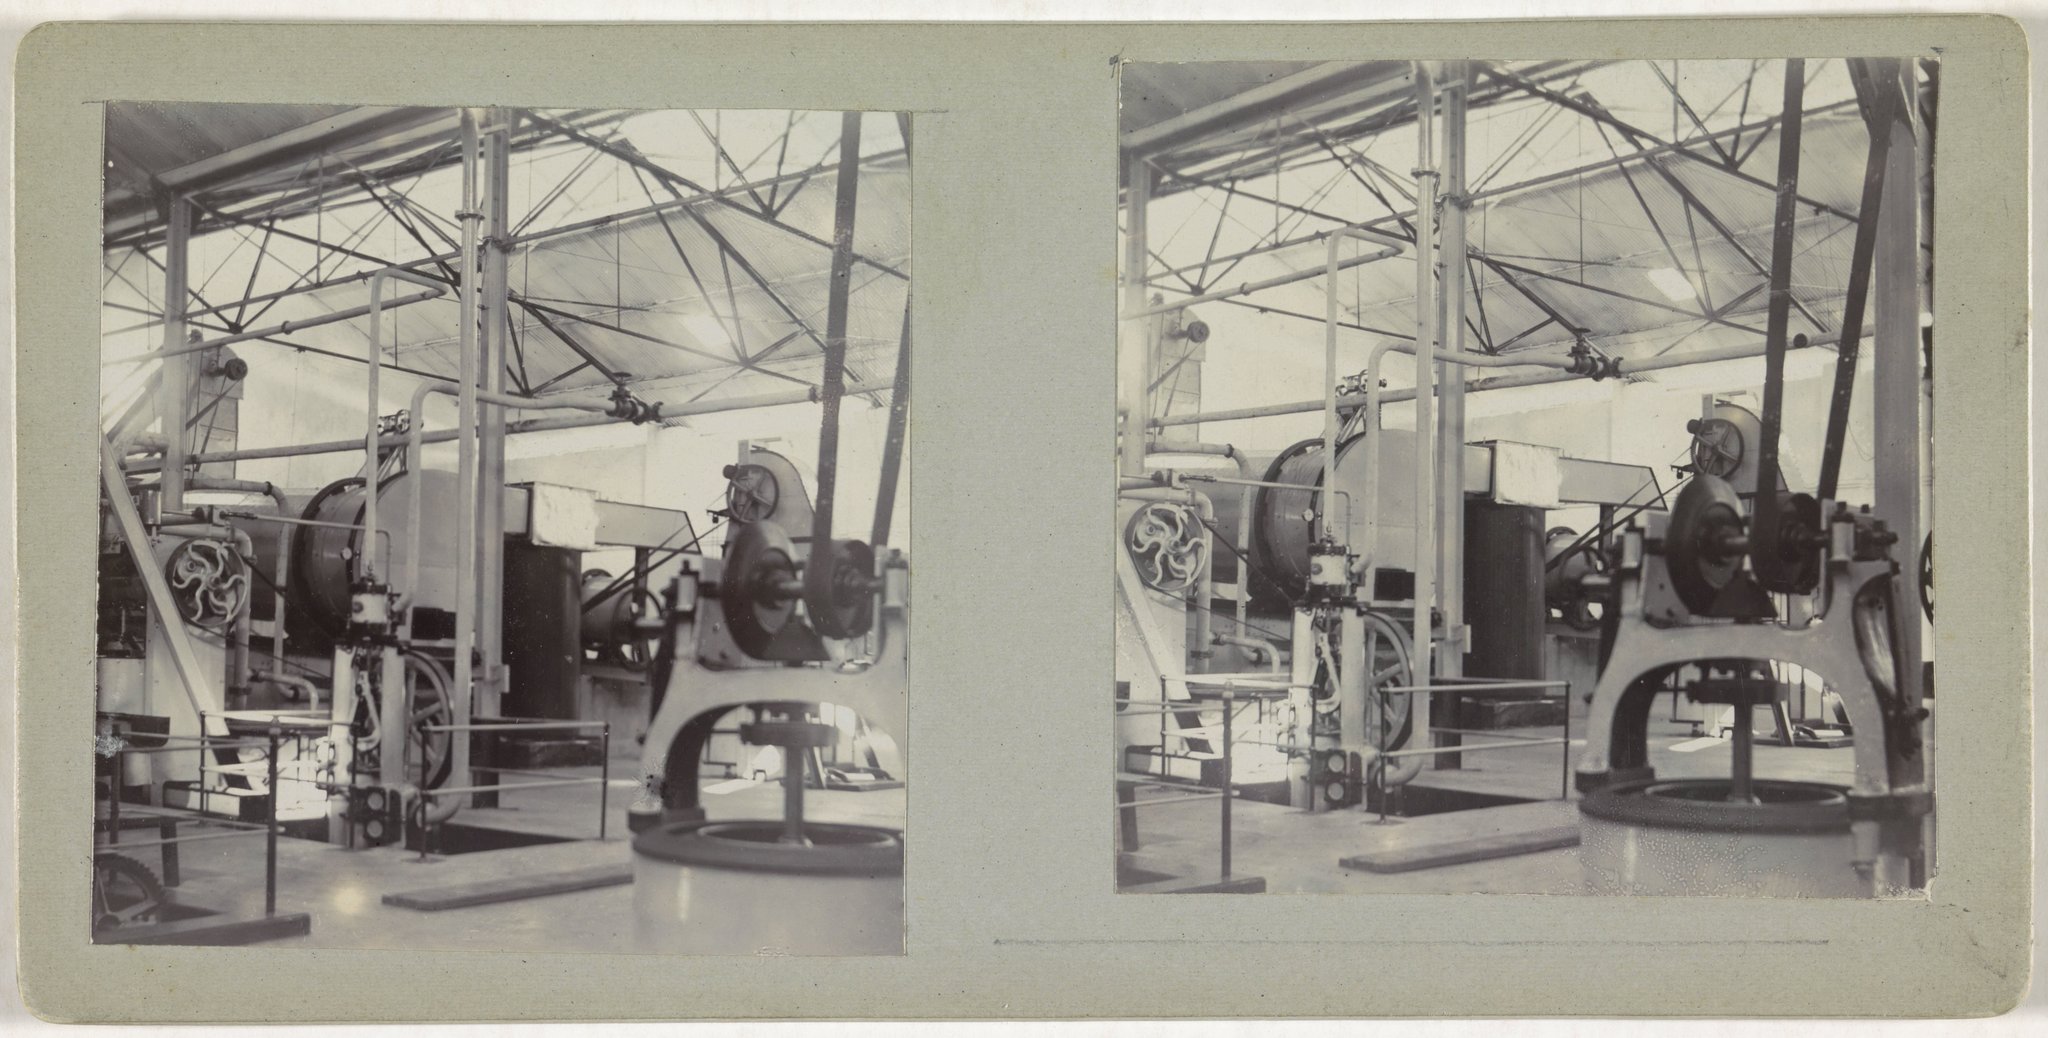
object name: stereograph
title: Interieur van suikerfabriek (?) Soemberkareng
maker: Anonymous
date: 1906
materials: cardboard, paper, photographic support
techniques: albumen print